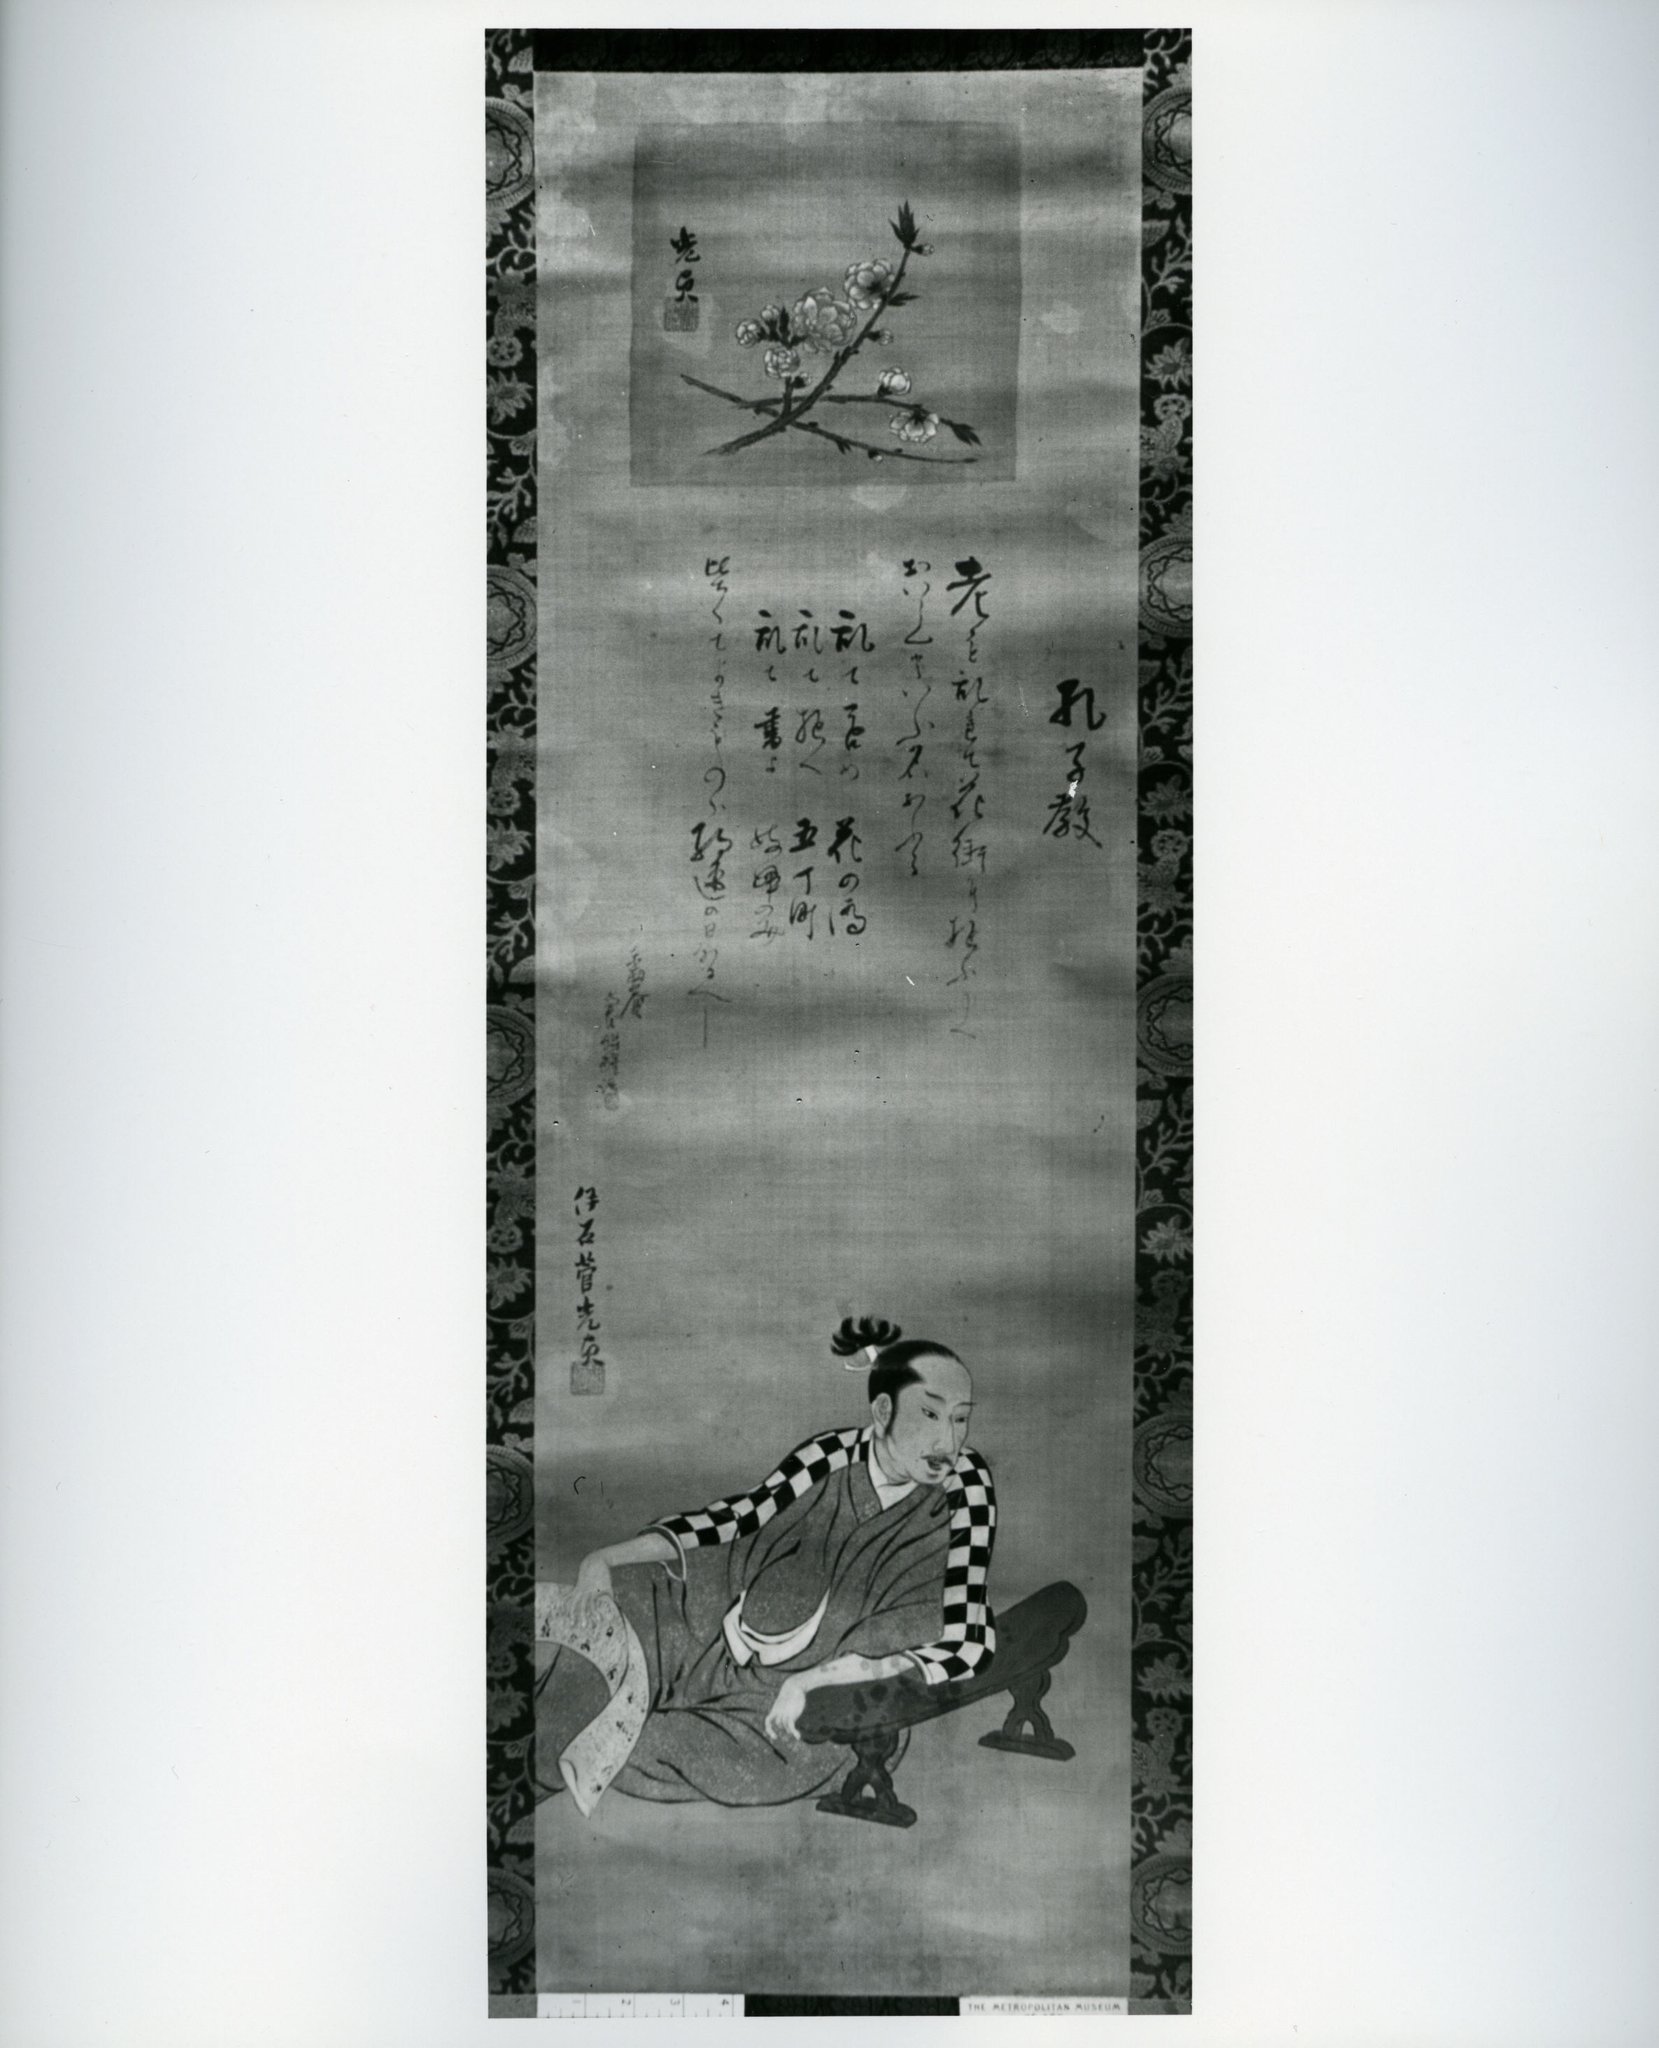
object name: hanging scroll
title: Pleasure Quarters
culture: japanese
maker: suga mitsusada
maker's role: artist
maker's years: 1738-1806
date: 1701-1900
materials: ink, silk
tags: men,flowers